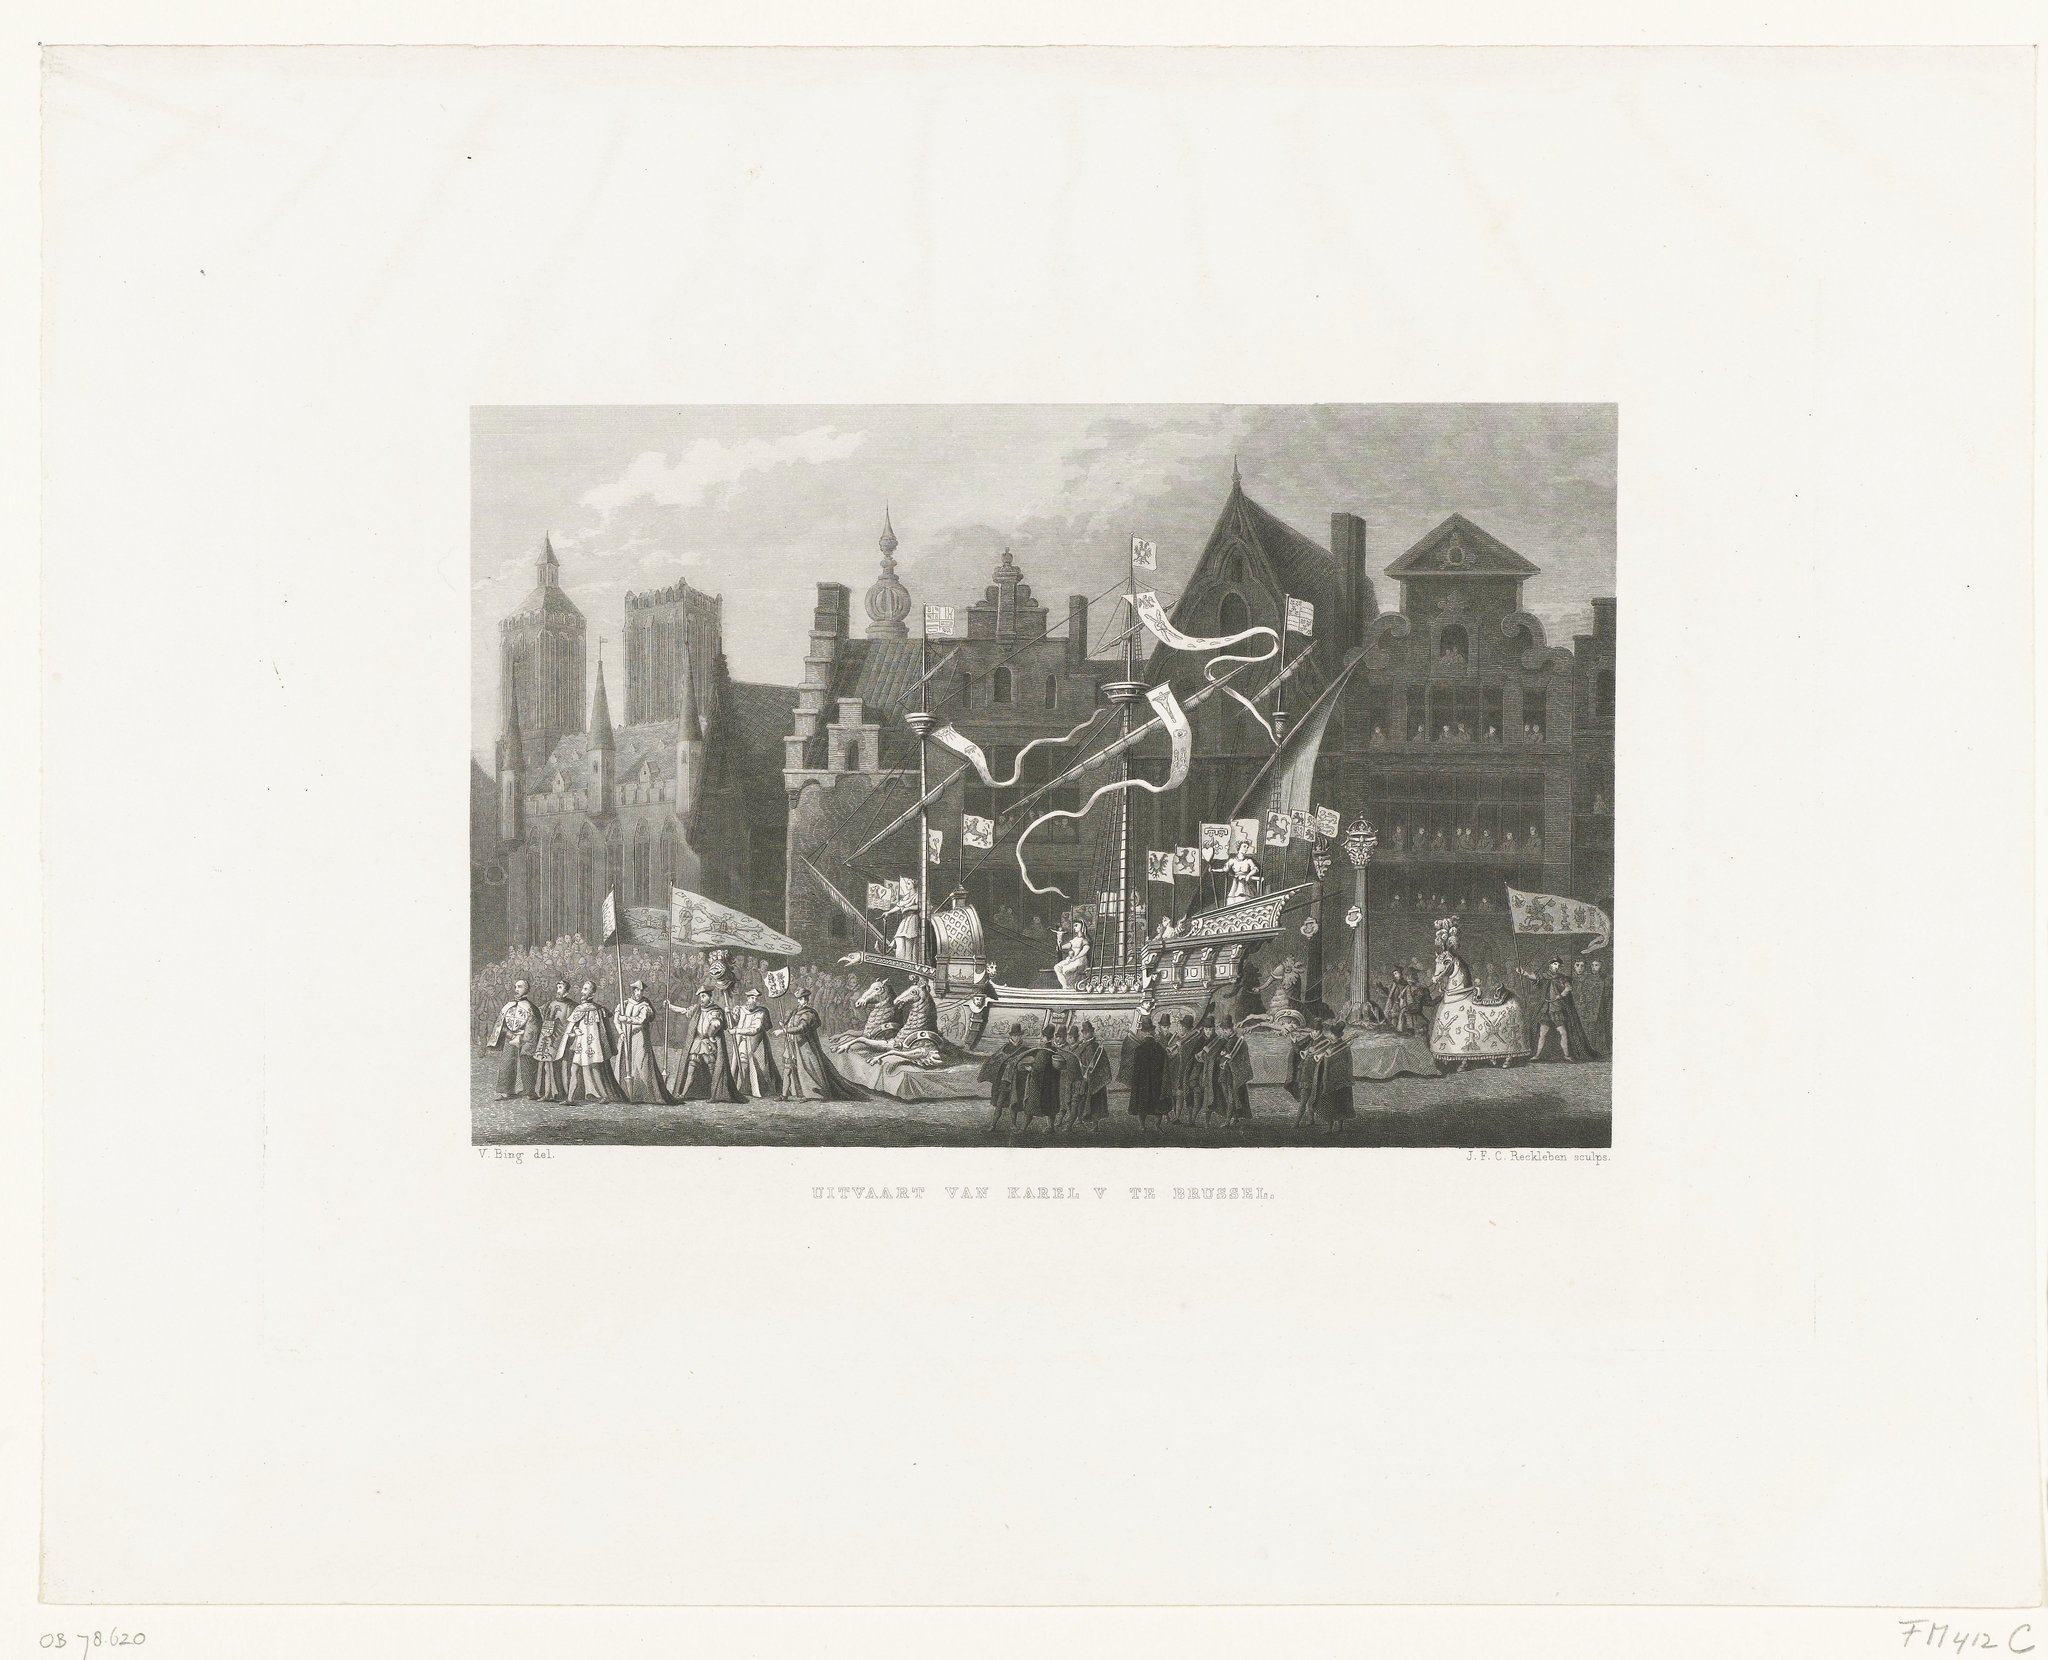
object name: print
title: Begrafenisoptocht van keizer Karel V, 1558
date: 1852-1854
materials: paper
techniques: engraving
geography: netherlands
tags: ghent, charles v (holy roman emperor and king of spain), cortege, funeral procession, brussels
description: Volgens FM afkomstig uit: Geschied. d. Christelijke Kerk, Amsterdam 1854, Dl. II. Dit boek heb ik niet kunnen traceren, wellicht wordt hier bedoeld: B. ter Haar en W. Moll, Geschiedenis der Christelijke Kerk in Nederland in tafereelen, 2 delen. Amsterdam 1864-1869.